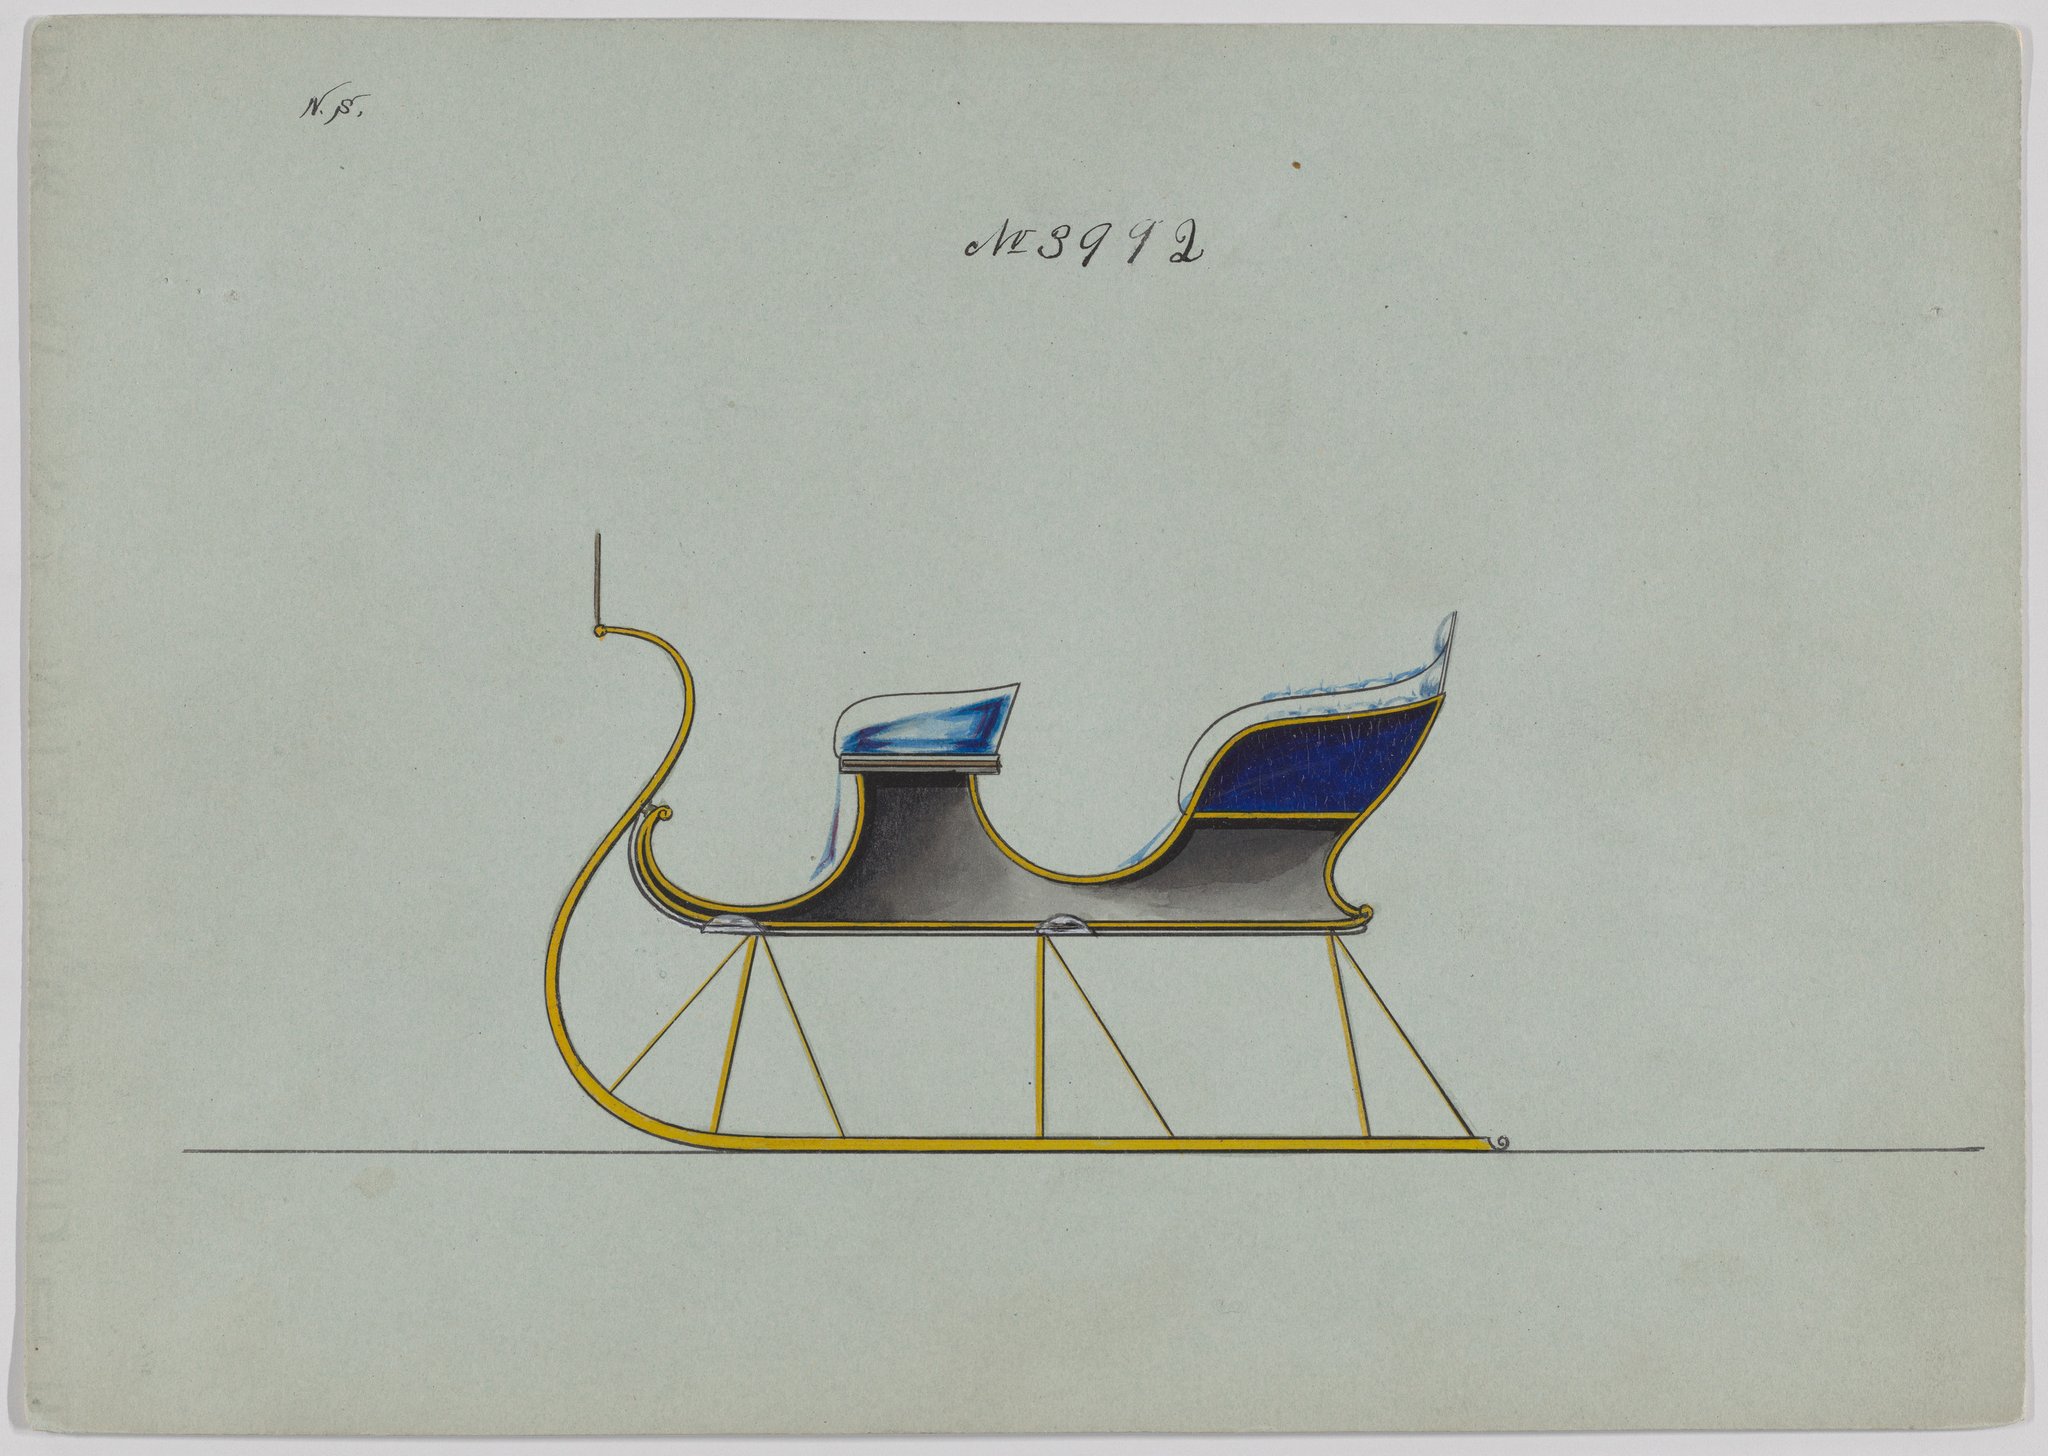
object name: drawing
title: Design for 4 Seat Sleigh, no. 3992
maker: brewster & co.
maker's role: manufacturer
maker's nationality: american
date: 1887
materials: gouache, gum arabic, ink, watercolor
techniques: pen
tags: sleighs